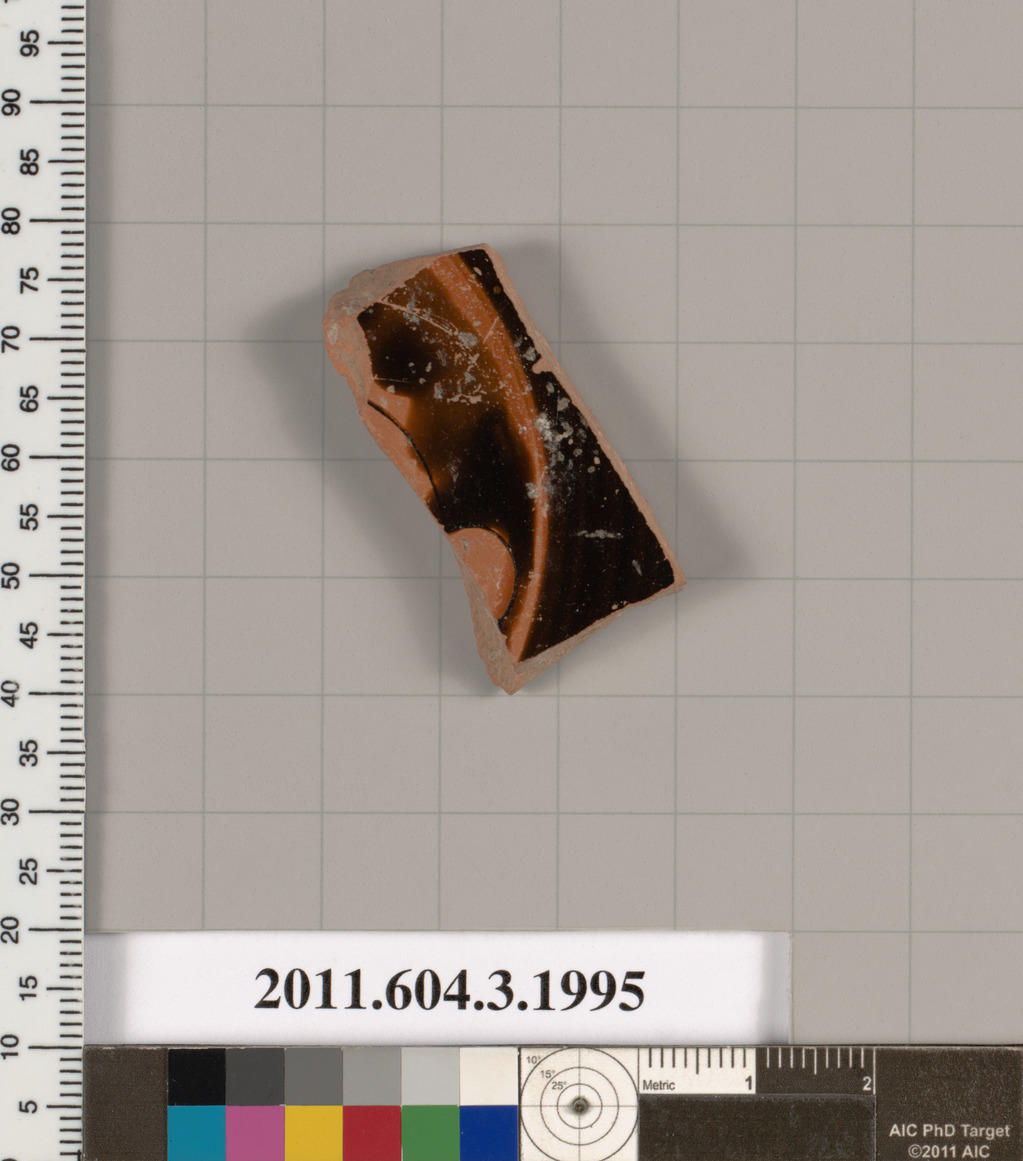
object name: kylix fragment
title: Terracotta fragment of a kylix (drinking cup)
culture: greek, attic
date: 550-526 BCE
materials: terracotta